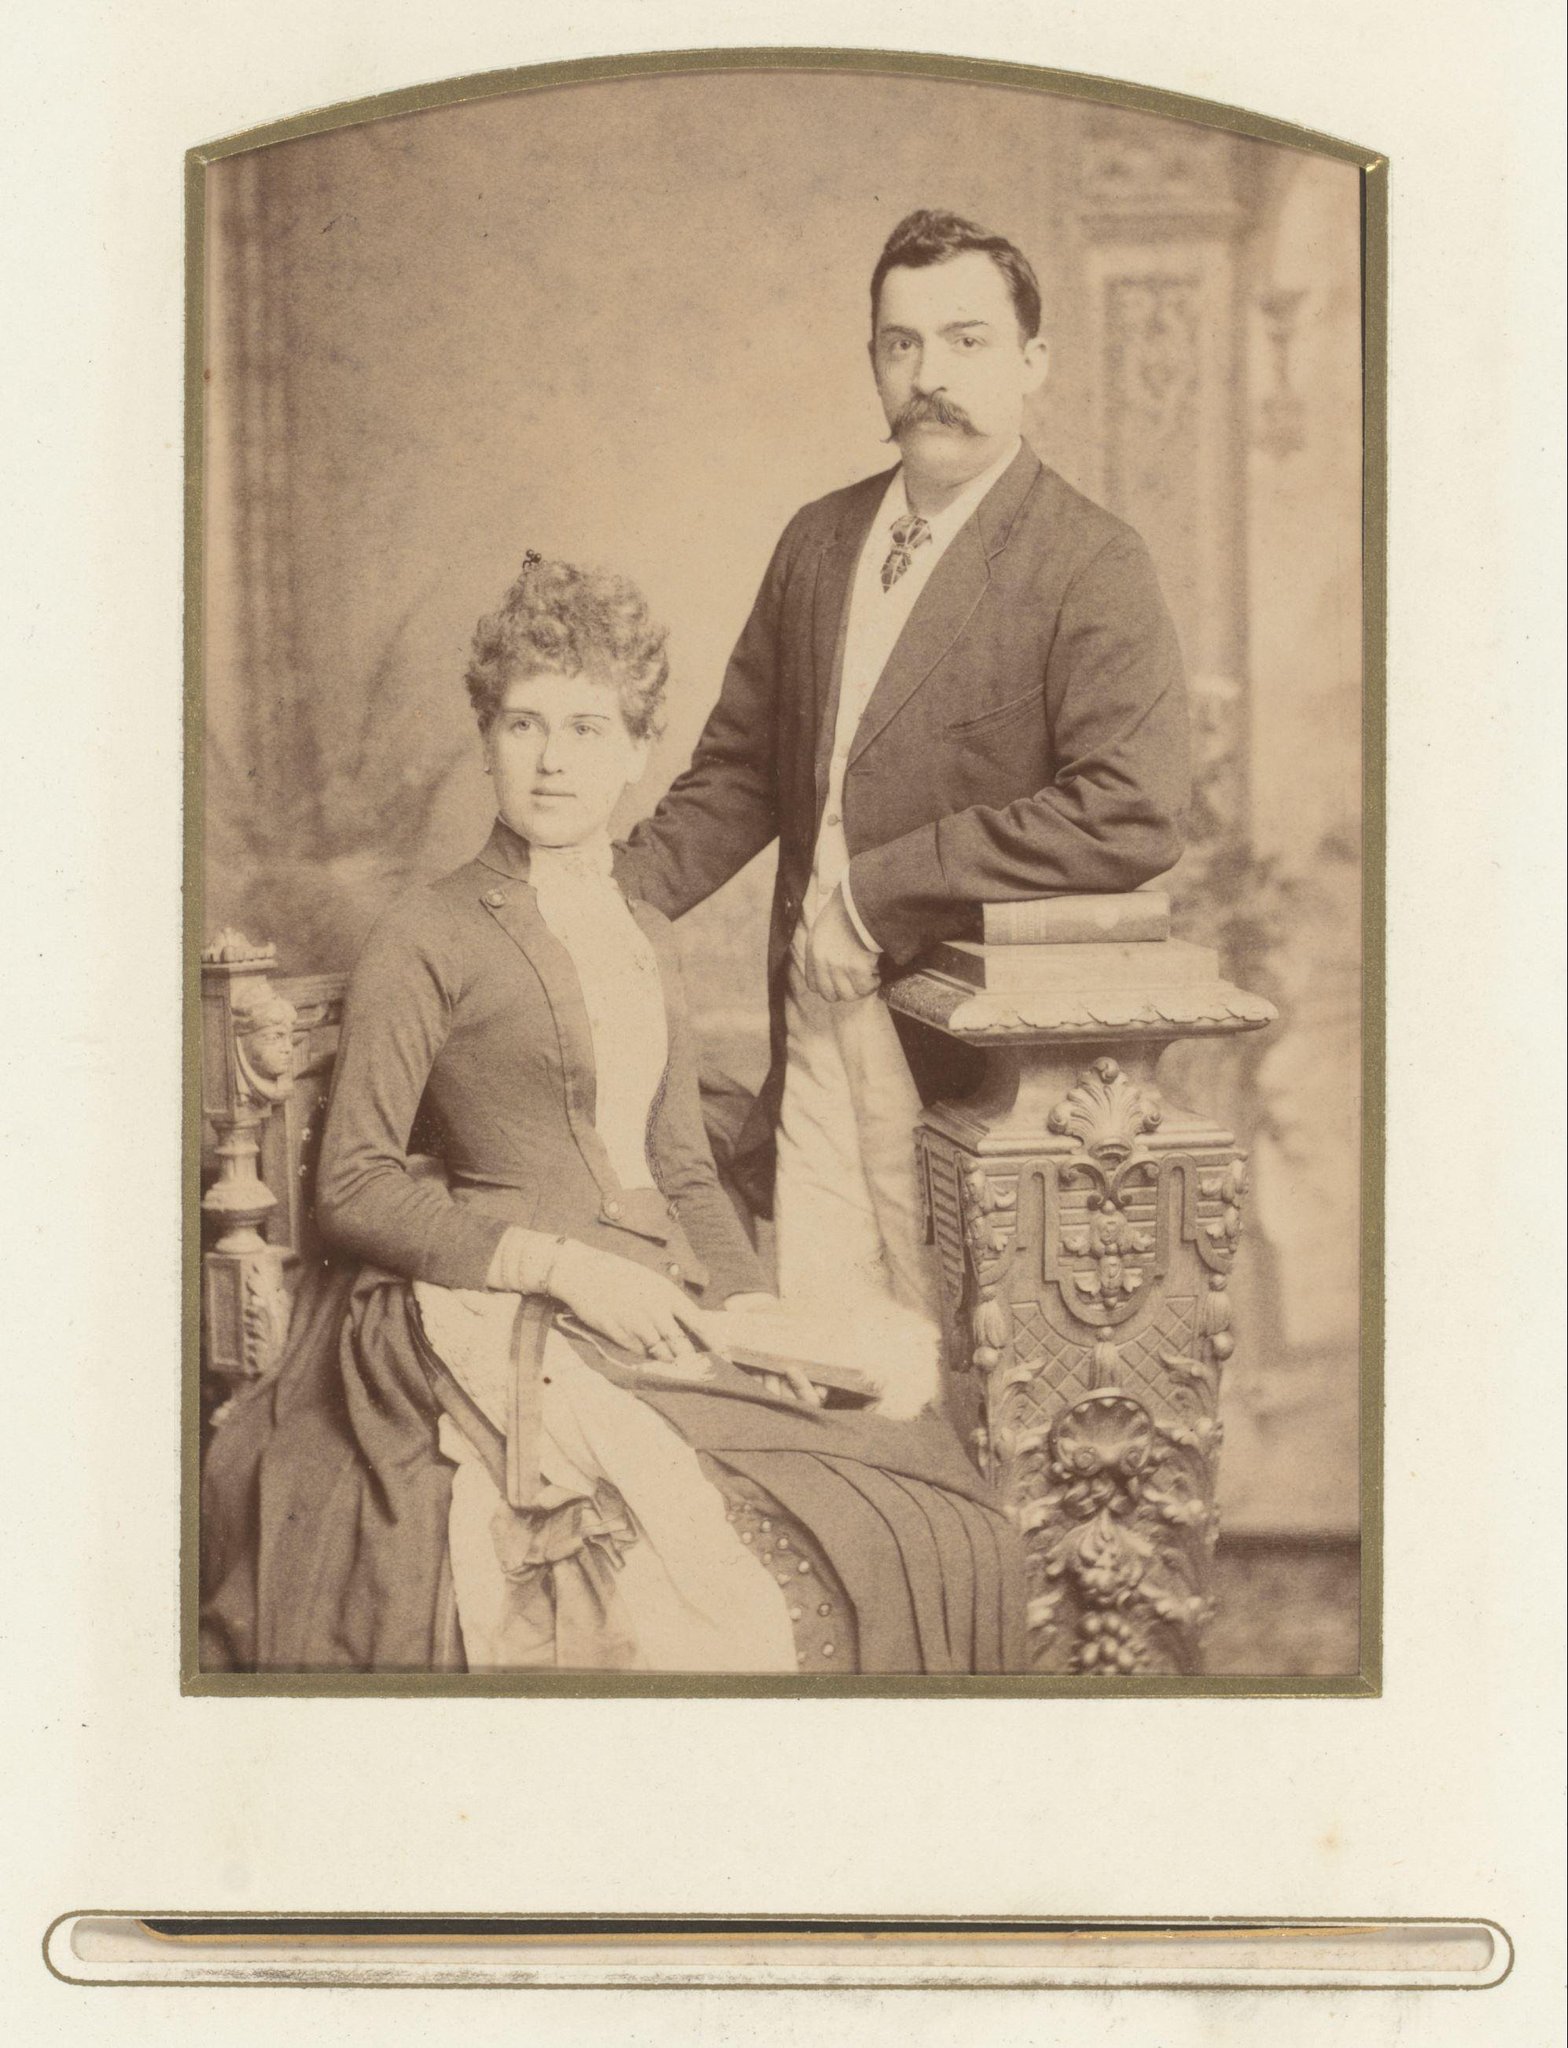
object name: cabinet photograph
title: Portret van een zittende vrouw met waaier en een staande man leunend op een zuil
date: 1884-1887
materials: cardboard, photographic support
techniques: albumen print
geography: surabaya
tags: historical persons - bb - woman, historical persons, fan, pedestal of a piece of sculpture (perhaps in the form of a herm)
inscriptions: inscription: ‘Charls & van Es Soerabaia’